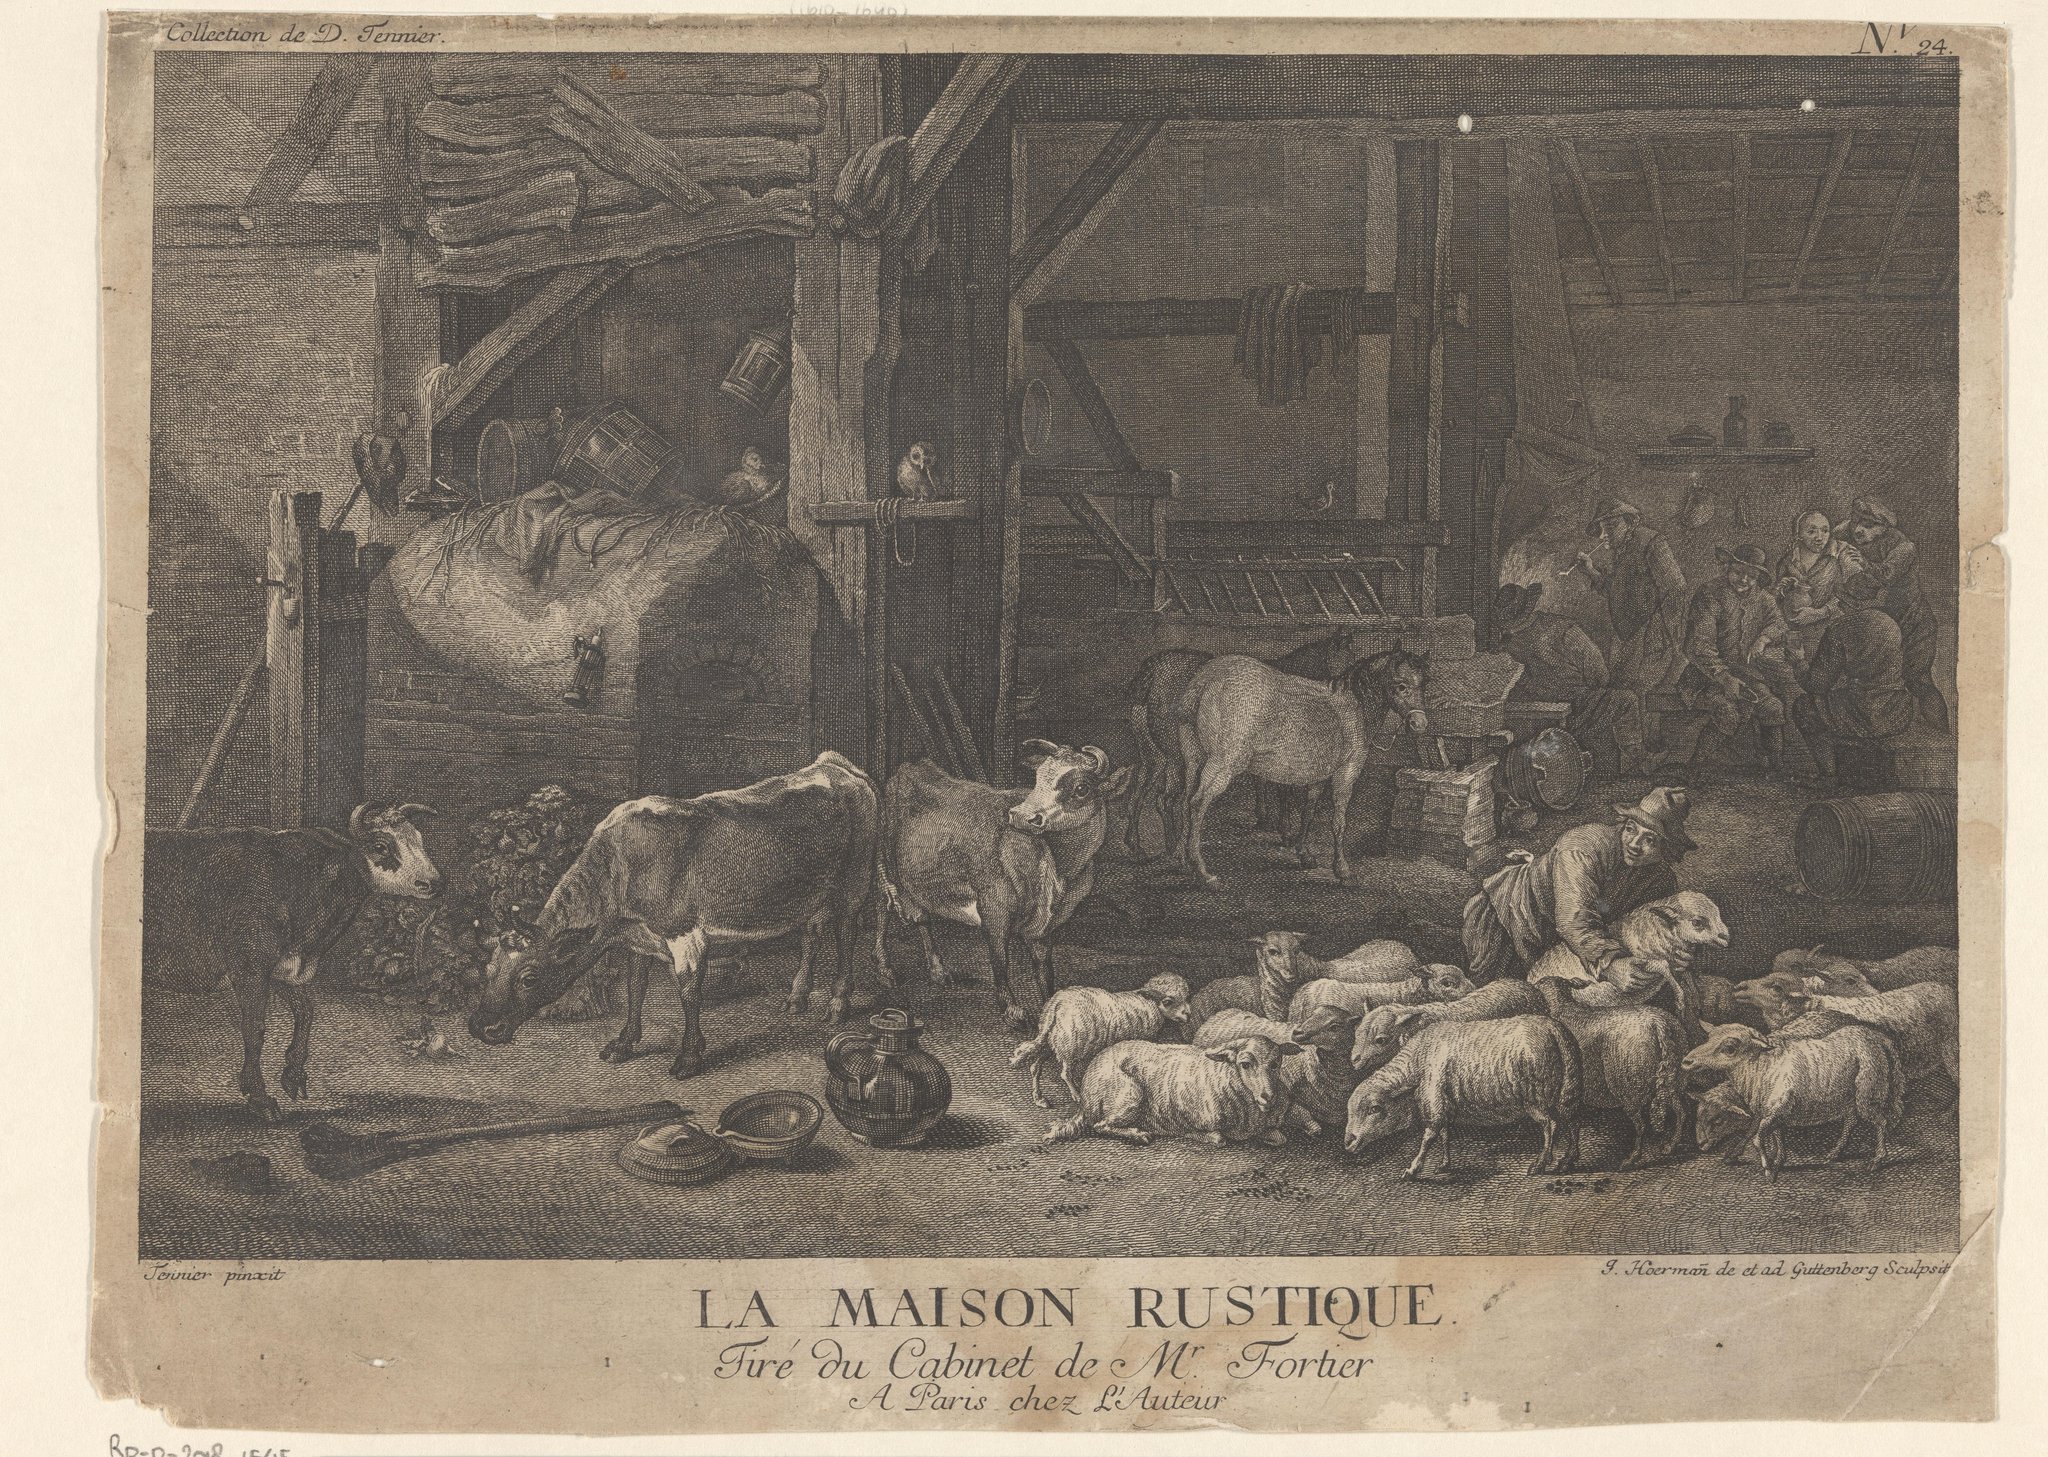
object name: print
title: Boerderij met vee en een groep drinkende mensen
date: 1700-1799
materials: paper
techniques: etching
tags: inn, coffee-house, public house, etc., farm (building) - aa - civic architecture: inside, cattle-breeding, livestock industry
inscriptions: collector's mark: Lugt 2228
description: Het schilderij was ten tijden van de vervaardiging van deze prent te vinden in de collectie van meneer Fortier.